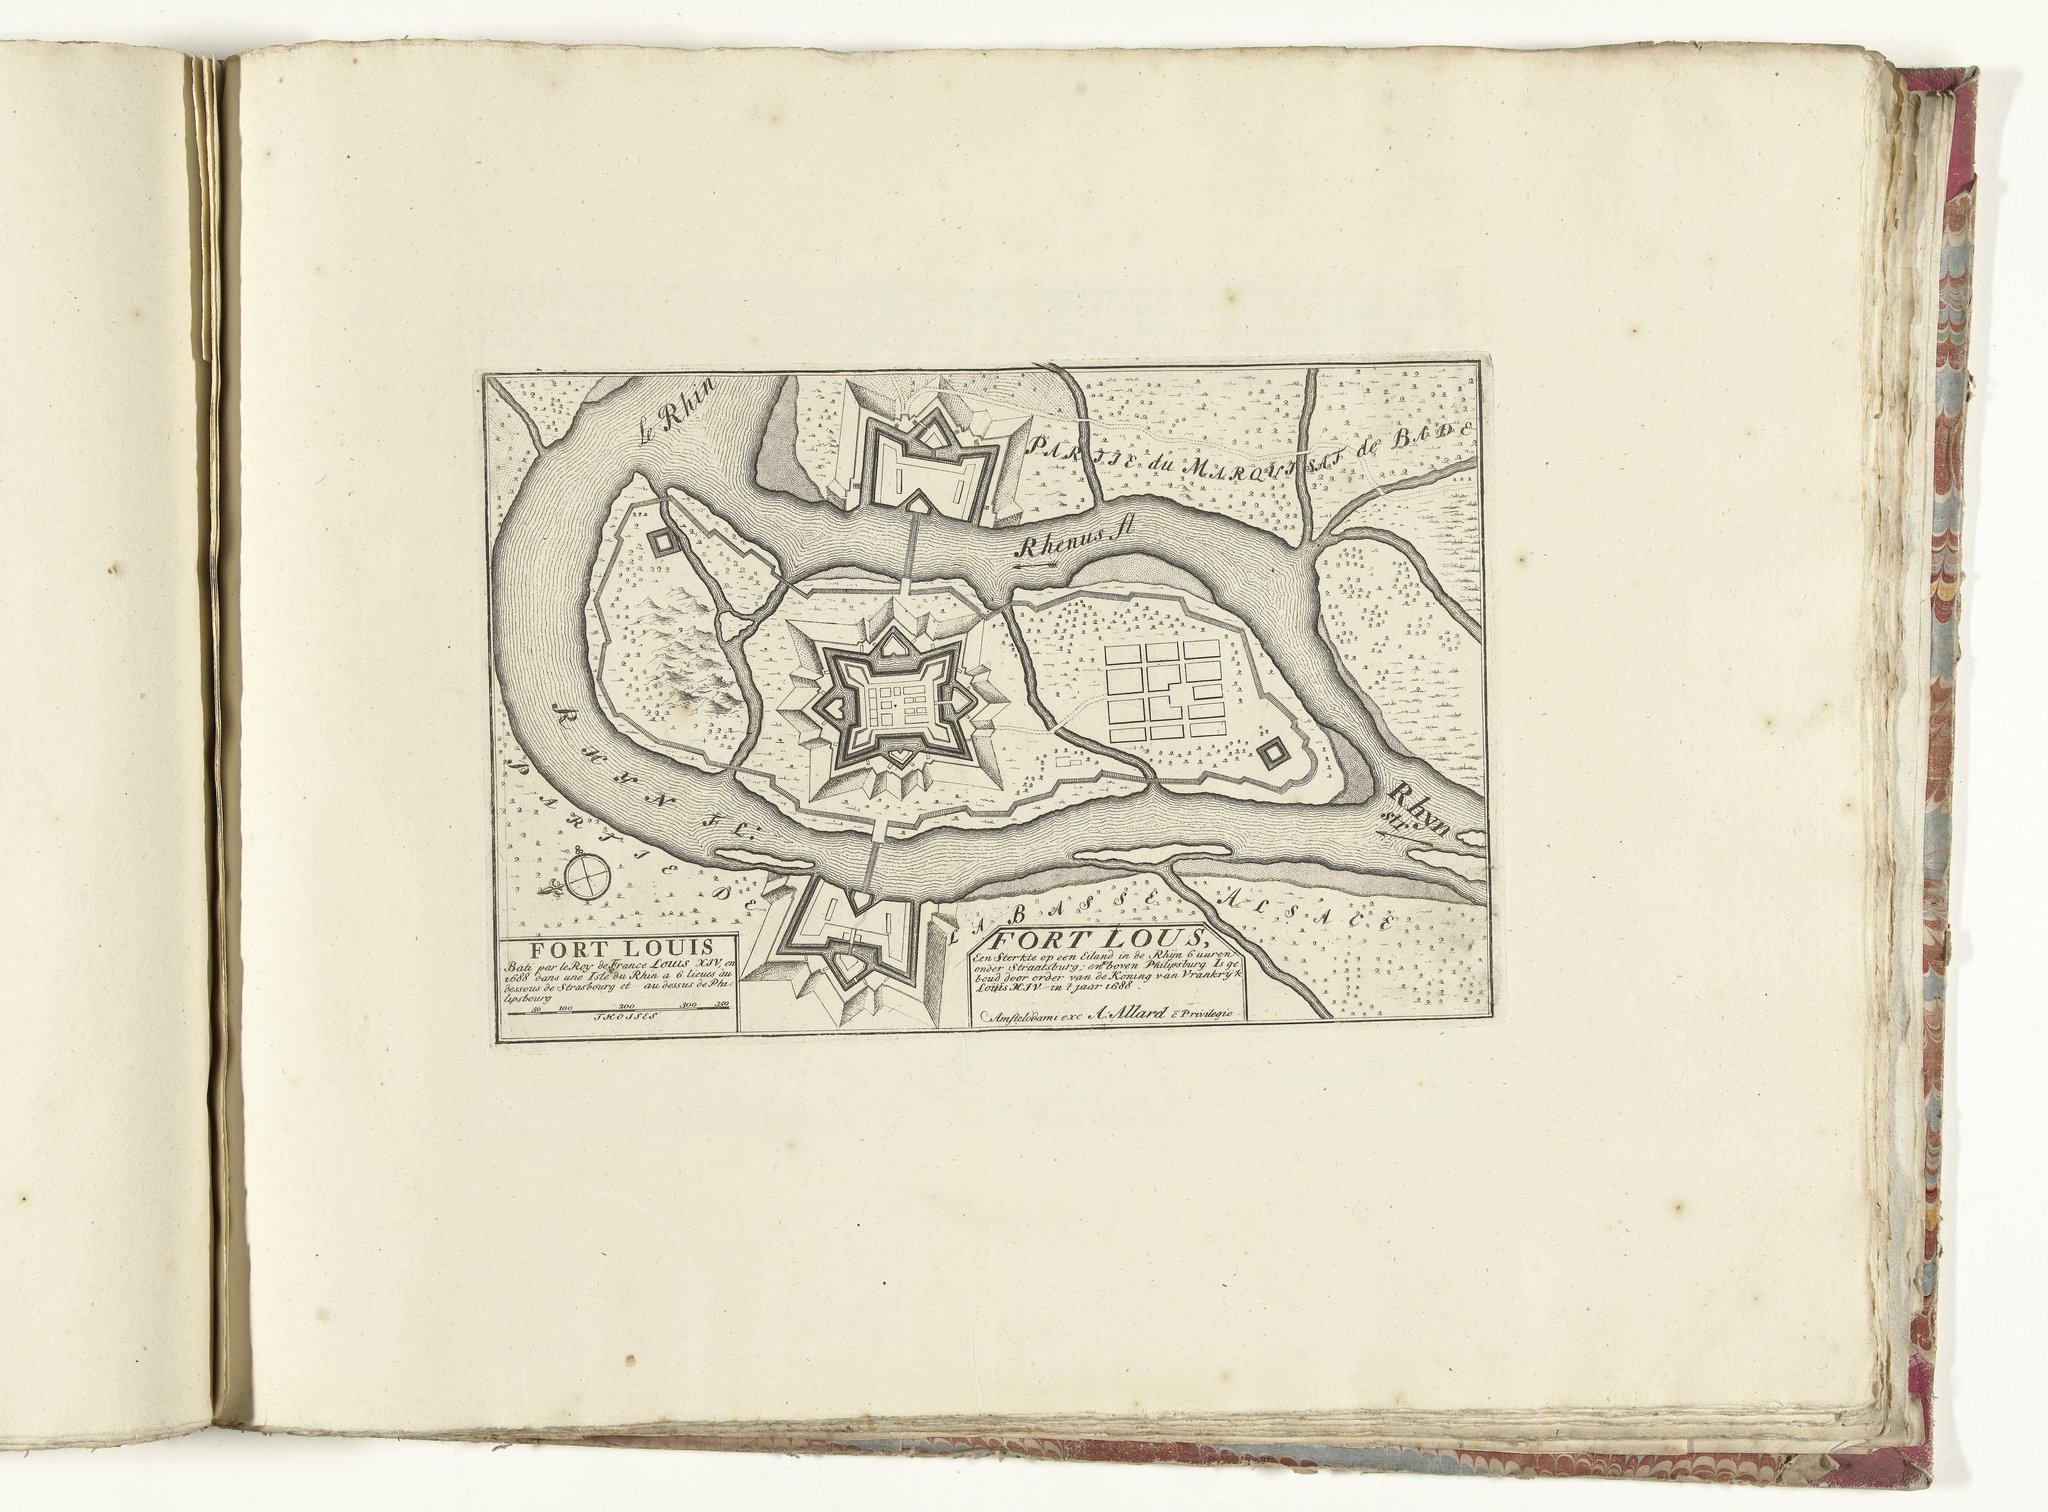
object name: map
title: Plattegrond van Fort Louis, ca. 1701-1713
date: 1701-1714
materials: paper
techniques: etching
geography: amsterdam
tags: fortress, maps of cities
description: Gekopieerd naar de Franse prenten in: Nicolas de Fer, Les forces de l'Europe, ou description des principales villes, avec leurs fortifications : dessignées par les meilleurs ingenieurs, particulierement celles ... de la France, dont les plans ont esté levez par M. de Vauban, Nicolas de Fer, Parijs 1693-1696, of andere voorbeelden.